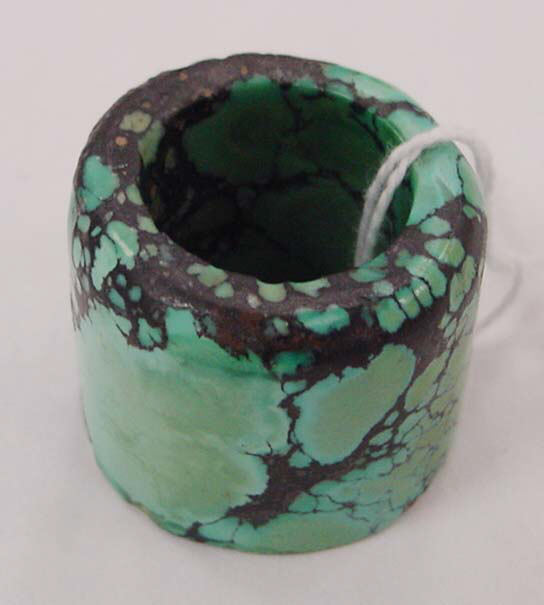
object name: ring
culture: chinese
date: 1801-1900